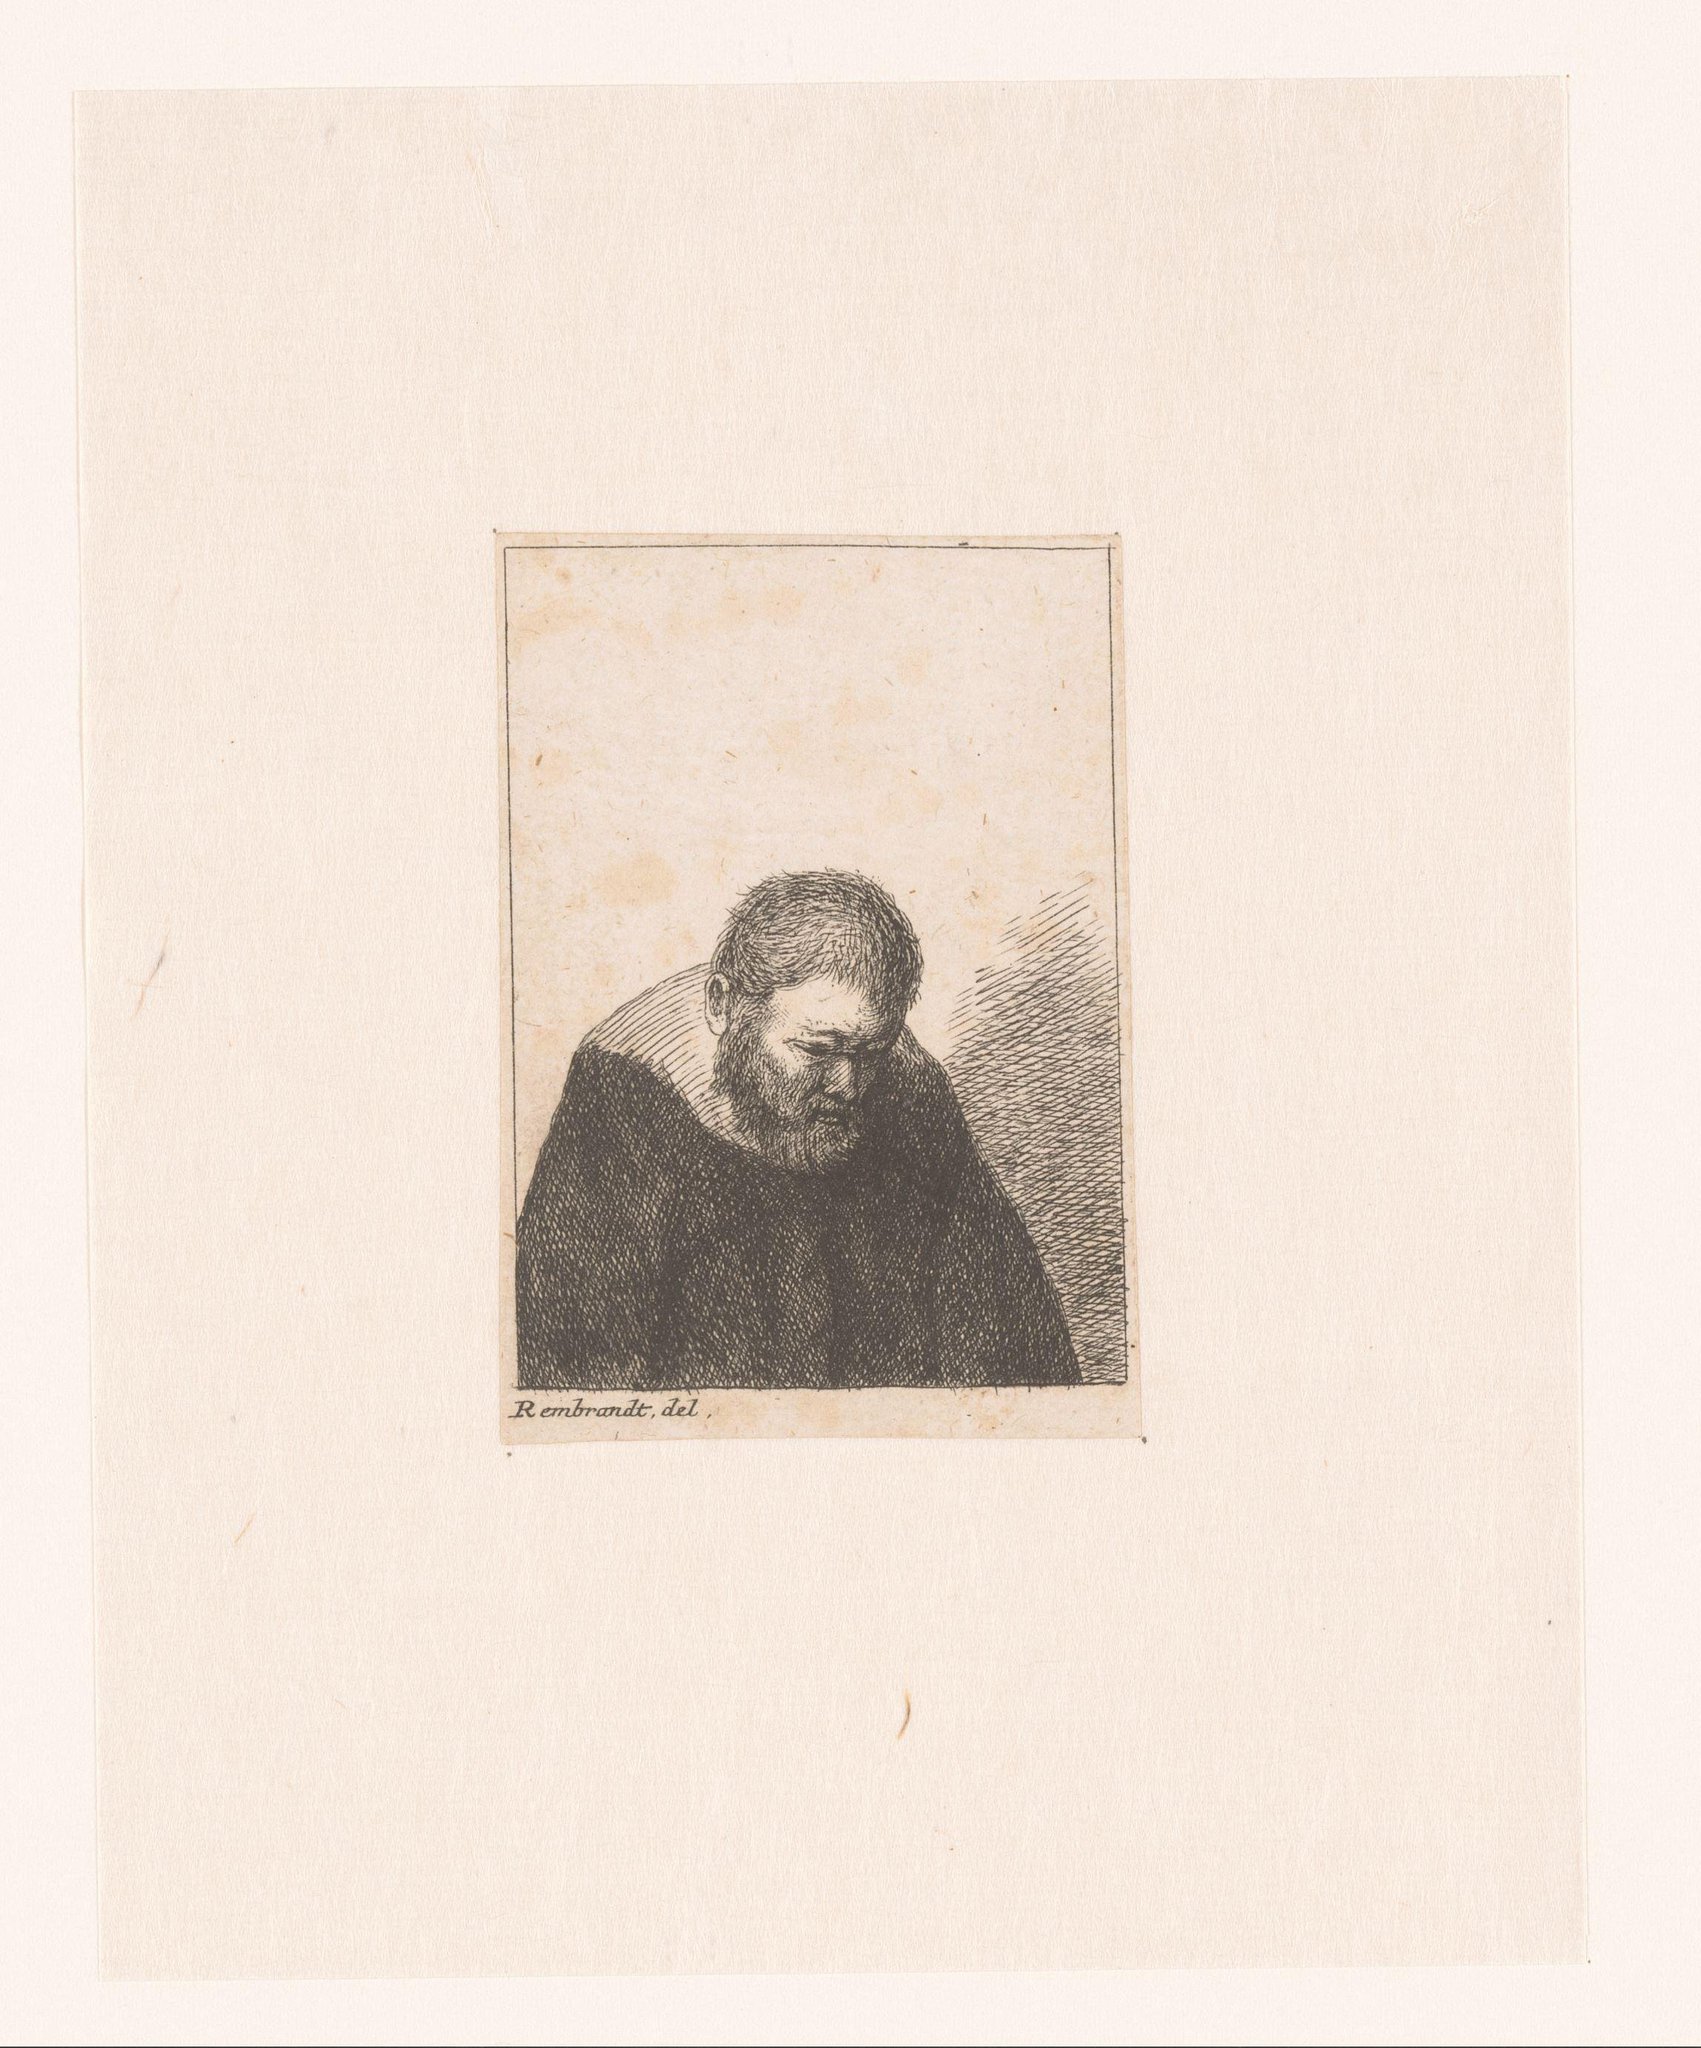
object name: print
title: Man met baard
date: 1700-1799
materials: paper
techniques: etching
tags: old man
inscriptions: collector's mark: Lugt 2760, collector's mark: Lugt 2228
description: Spiegelbeeldige kopie naar de gelijknamige prent mogelijk van Jan Lievens.